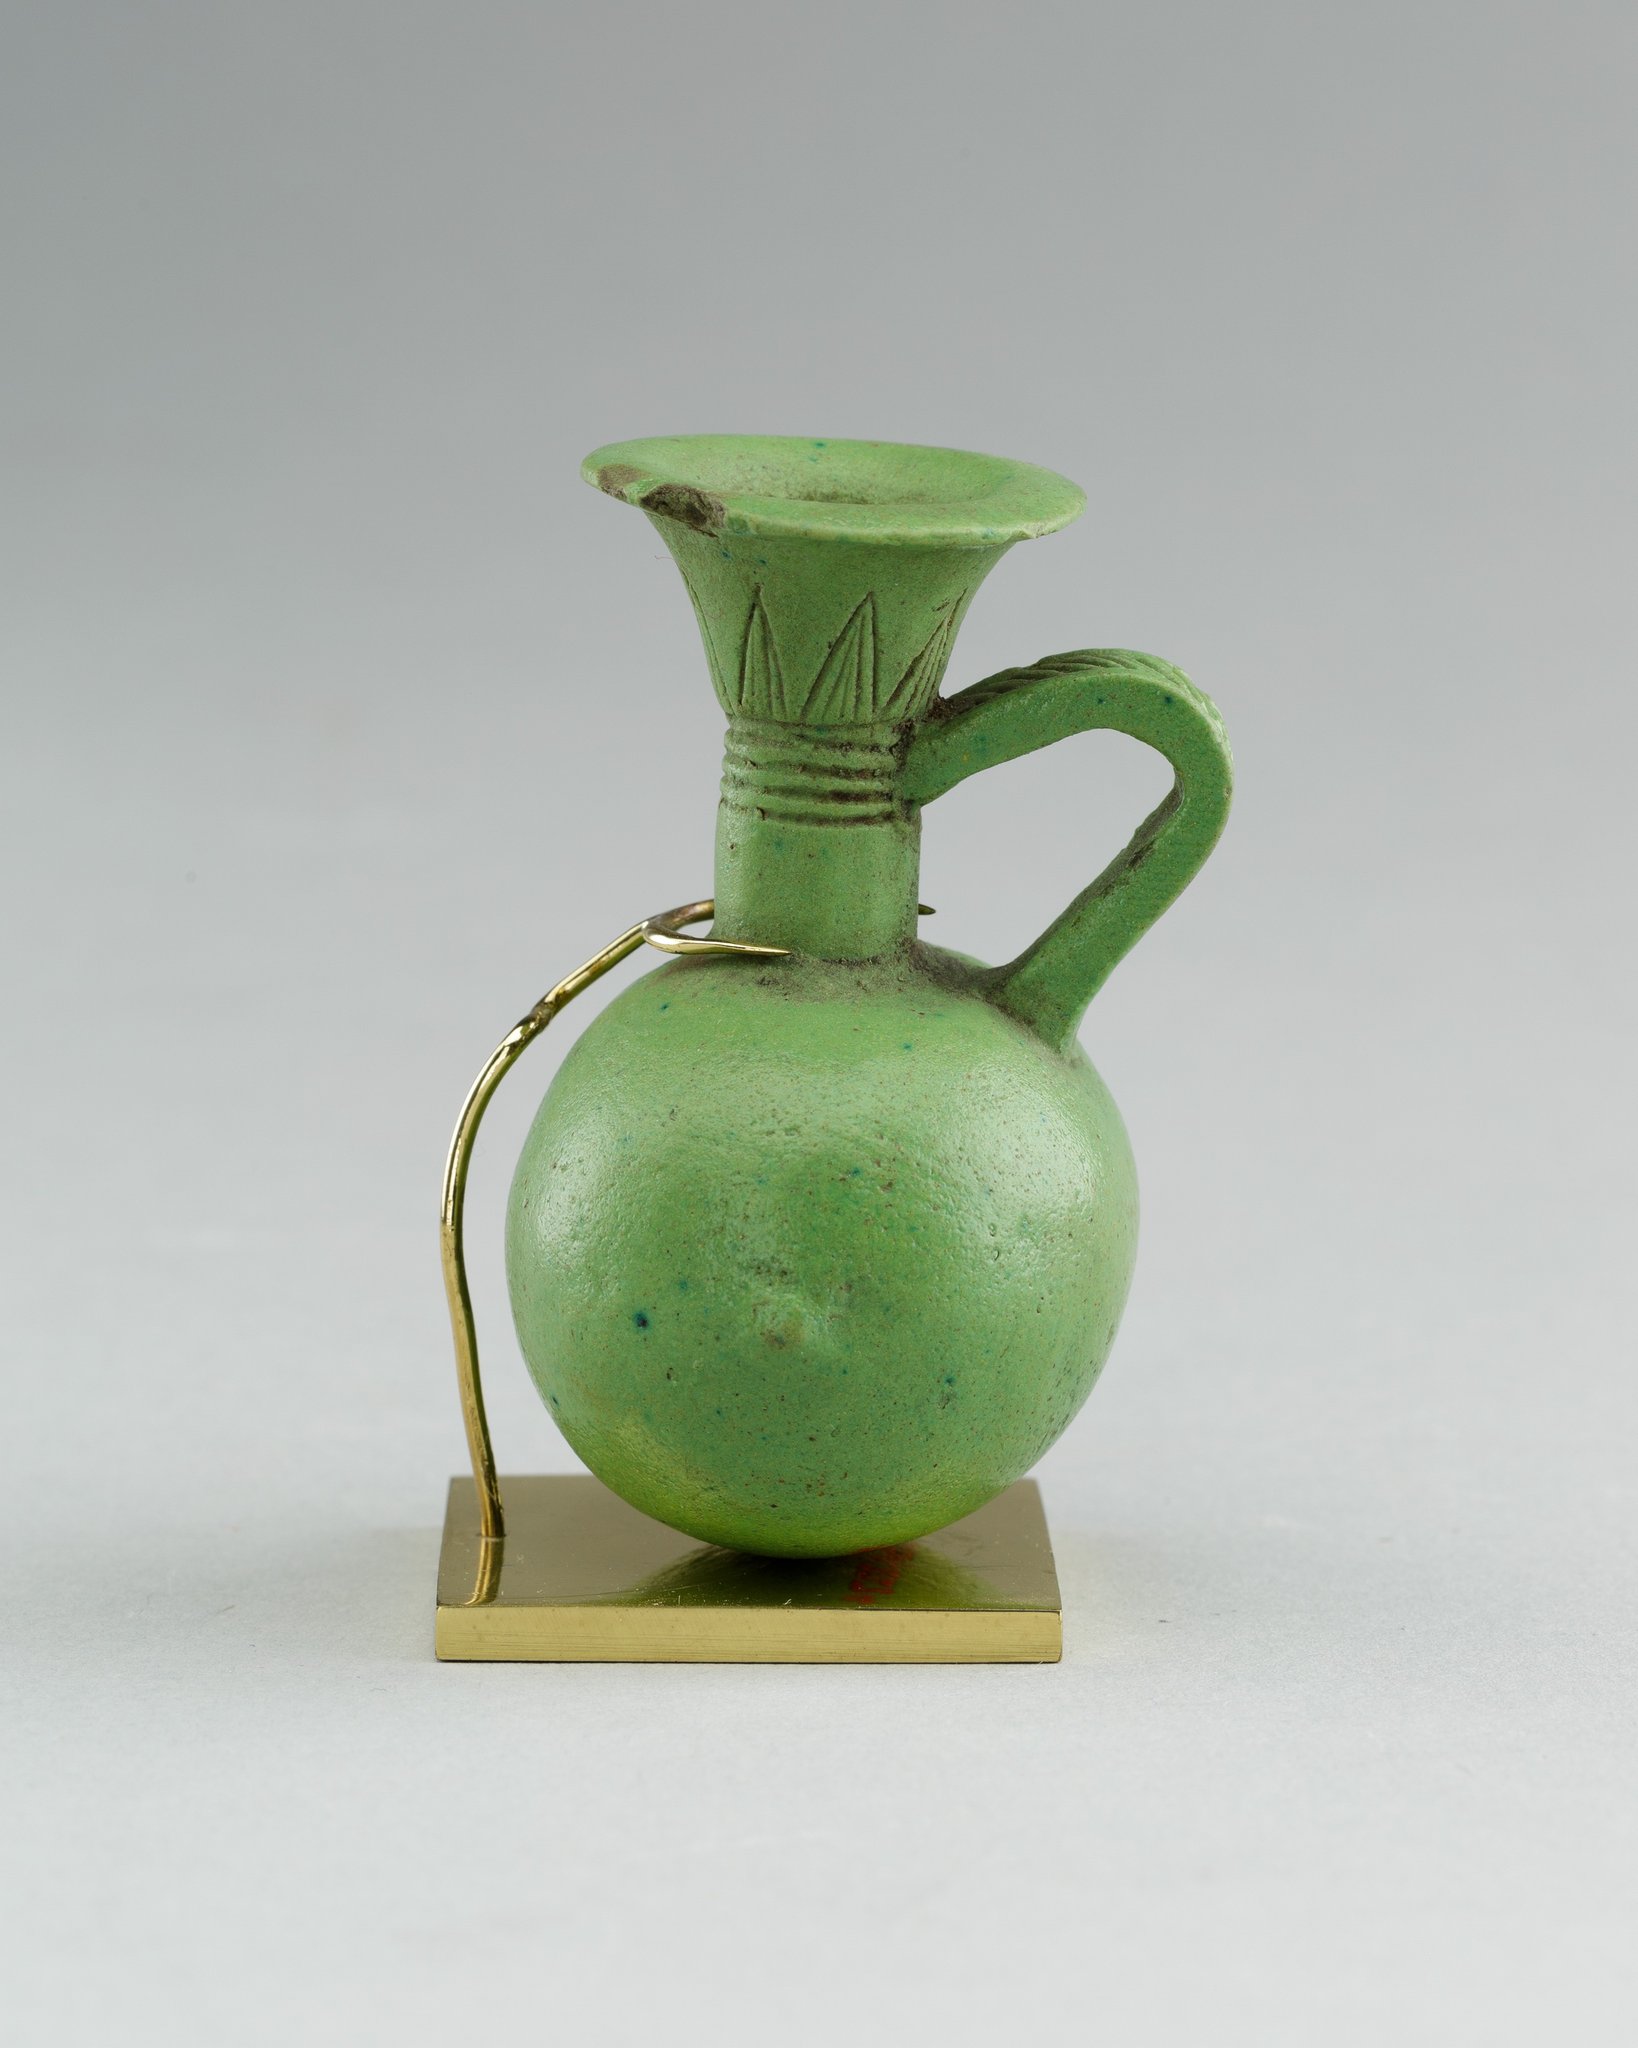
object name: handle for vessel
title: Small Jug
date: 664-380 BCE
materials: faience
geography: egypt